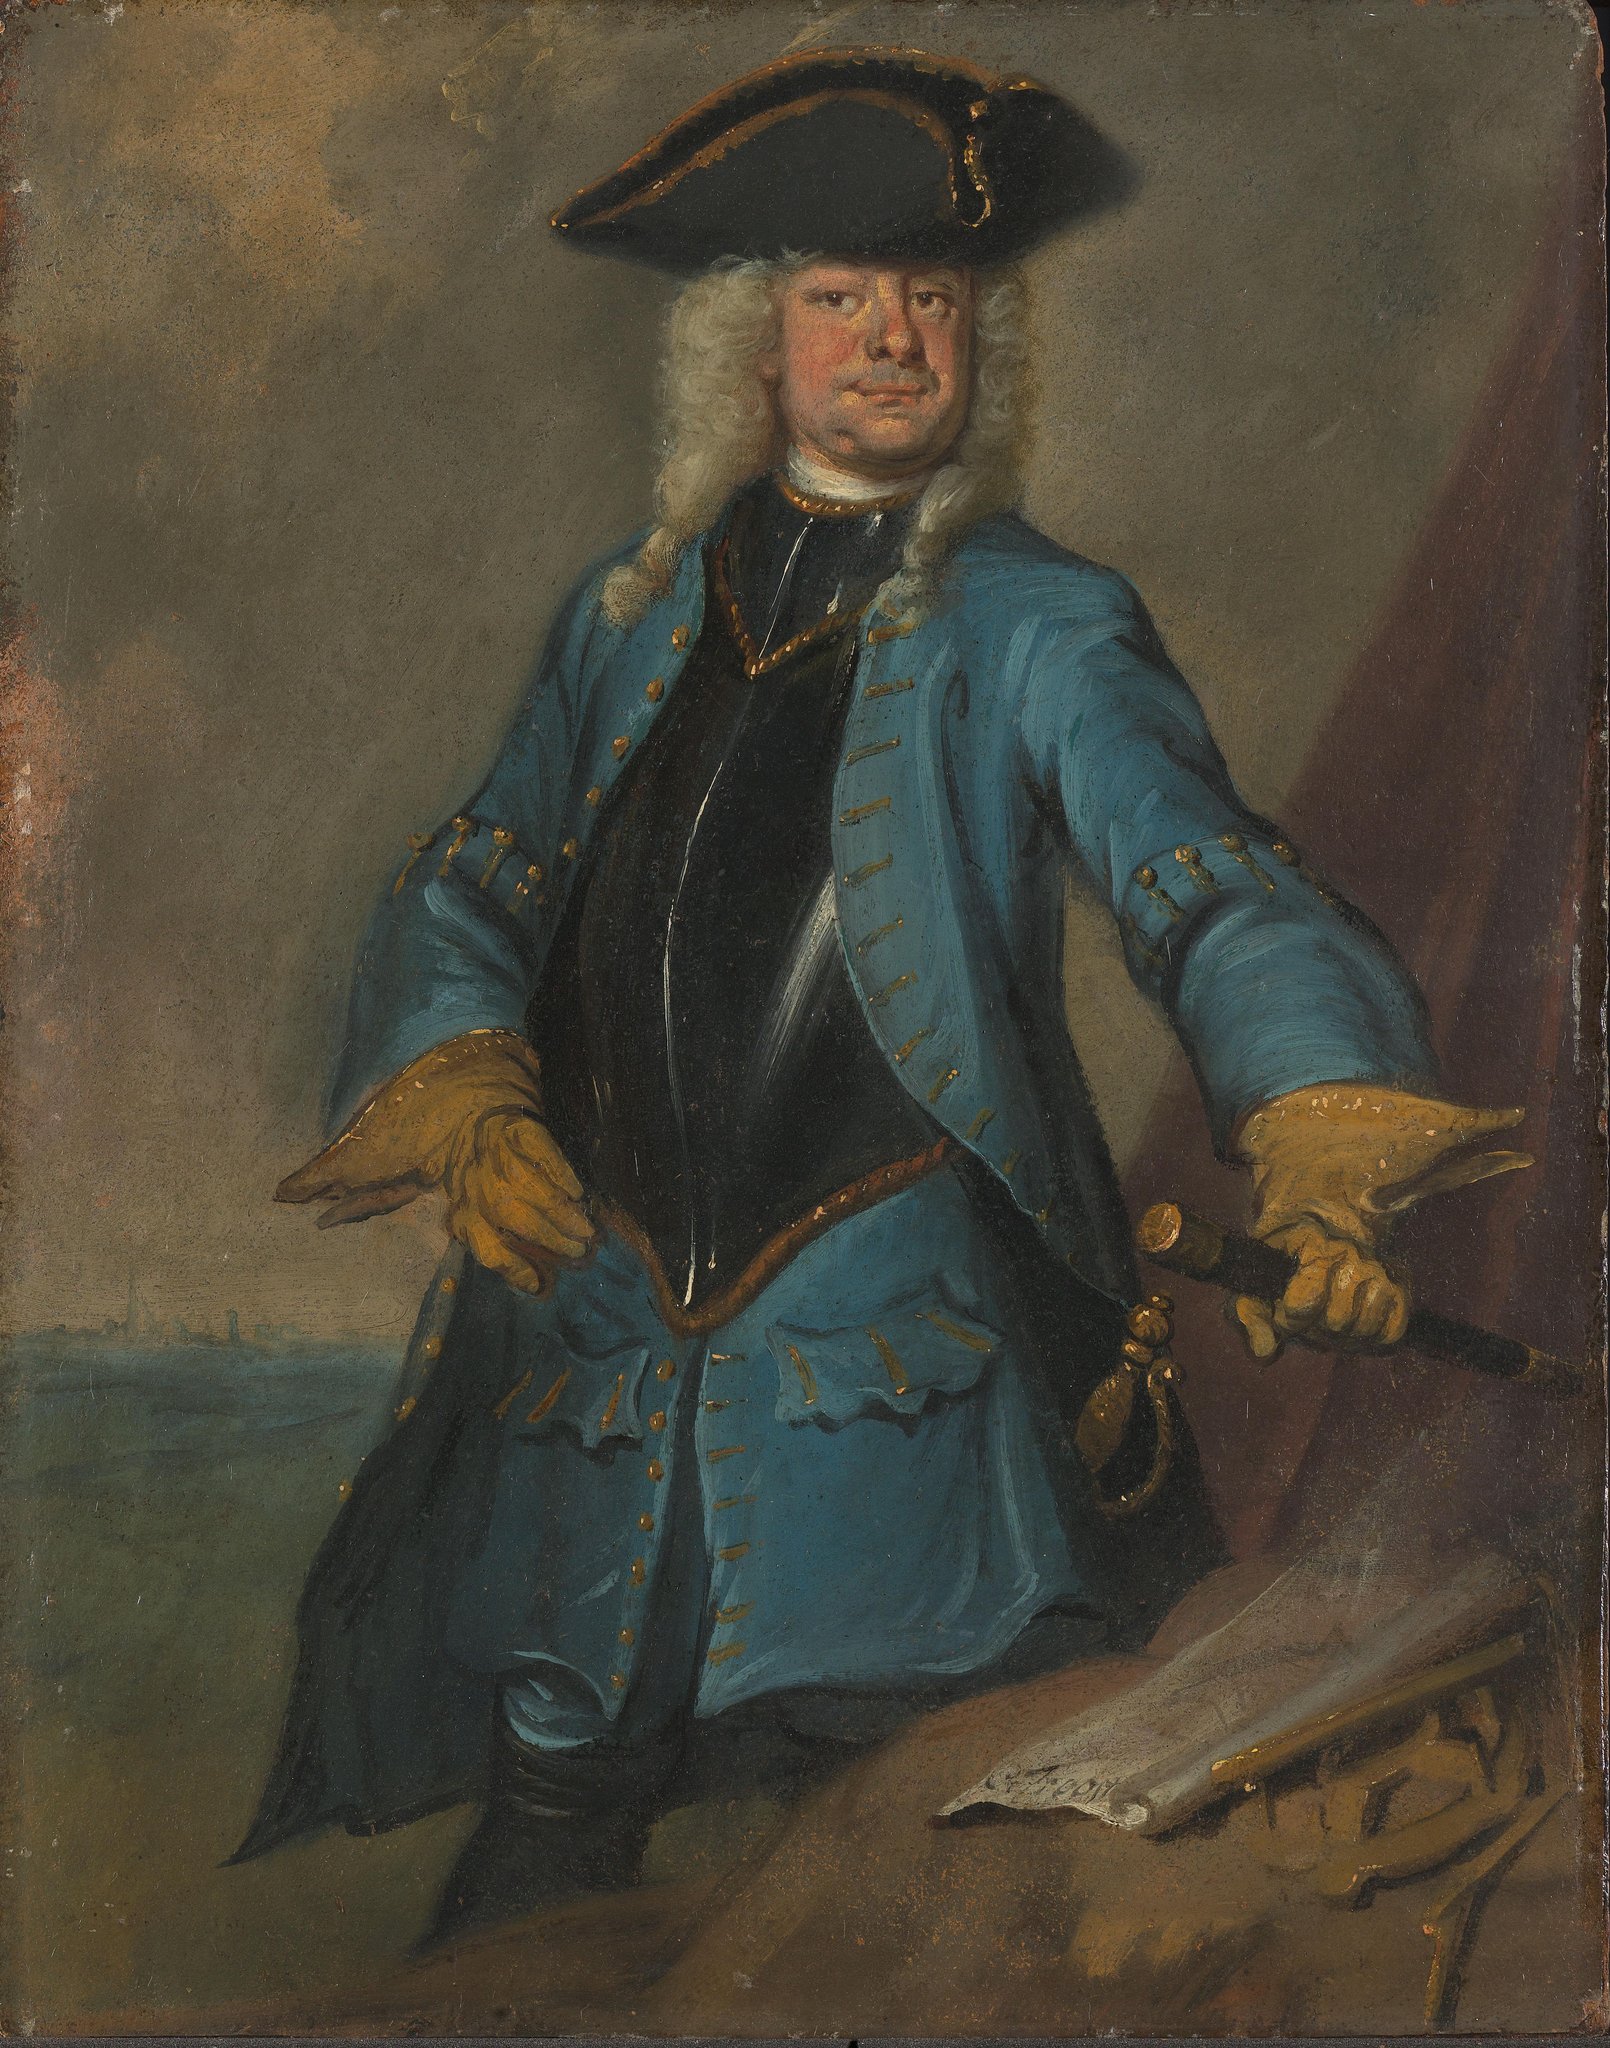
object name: preparatory study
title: Gerrit Sichterman (1688-1730). Quartermaster-General of the Cavalry, Colonel of the Oranje-Groningen Infantry Regiment, Commandant of Grave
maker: cornelis troost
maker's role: draughtsman, painter, print maker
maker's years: 1696-1750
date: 1725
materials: oil, panel, paper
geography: northern netherlands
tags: historical persons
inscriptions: signature: ‘C. Troost’, inscription: ‘Gerrit Sichterman, Generaele Quartiermeester van H. Hoogmogenden Cavallerie, Collonel van een Regement Infanterie, broer van Jan Albert’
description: Portret van Gerrit Sichterman (1688-1730). Generaal kwartiermeester der cavalerie, kolonel van het regiment infanterie Oranje-Groningen en commandant van Grave. Kniestuk, staande bij een legertent met een commadostaf in de linkerhand, de rechterhand in de zij.